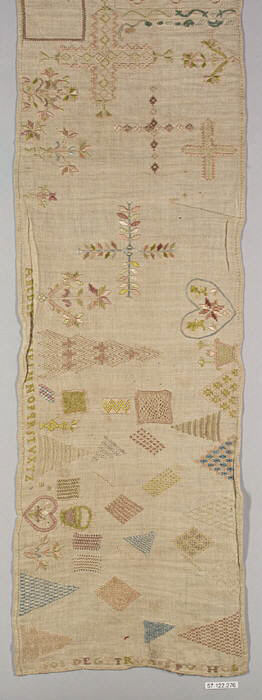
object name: sampler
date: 1801-1900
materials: linen, silk